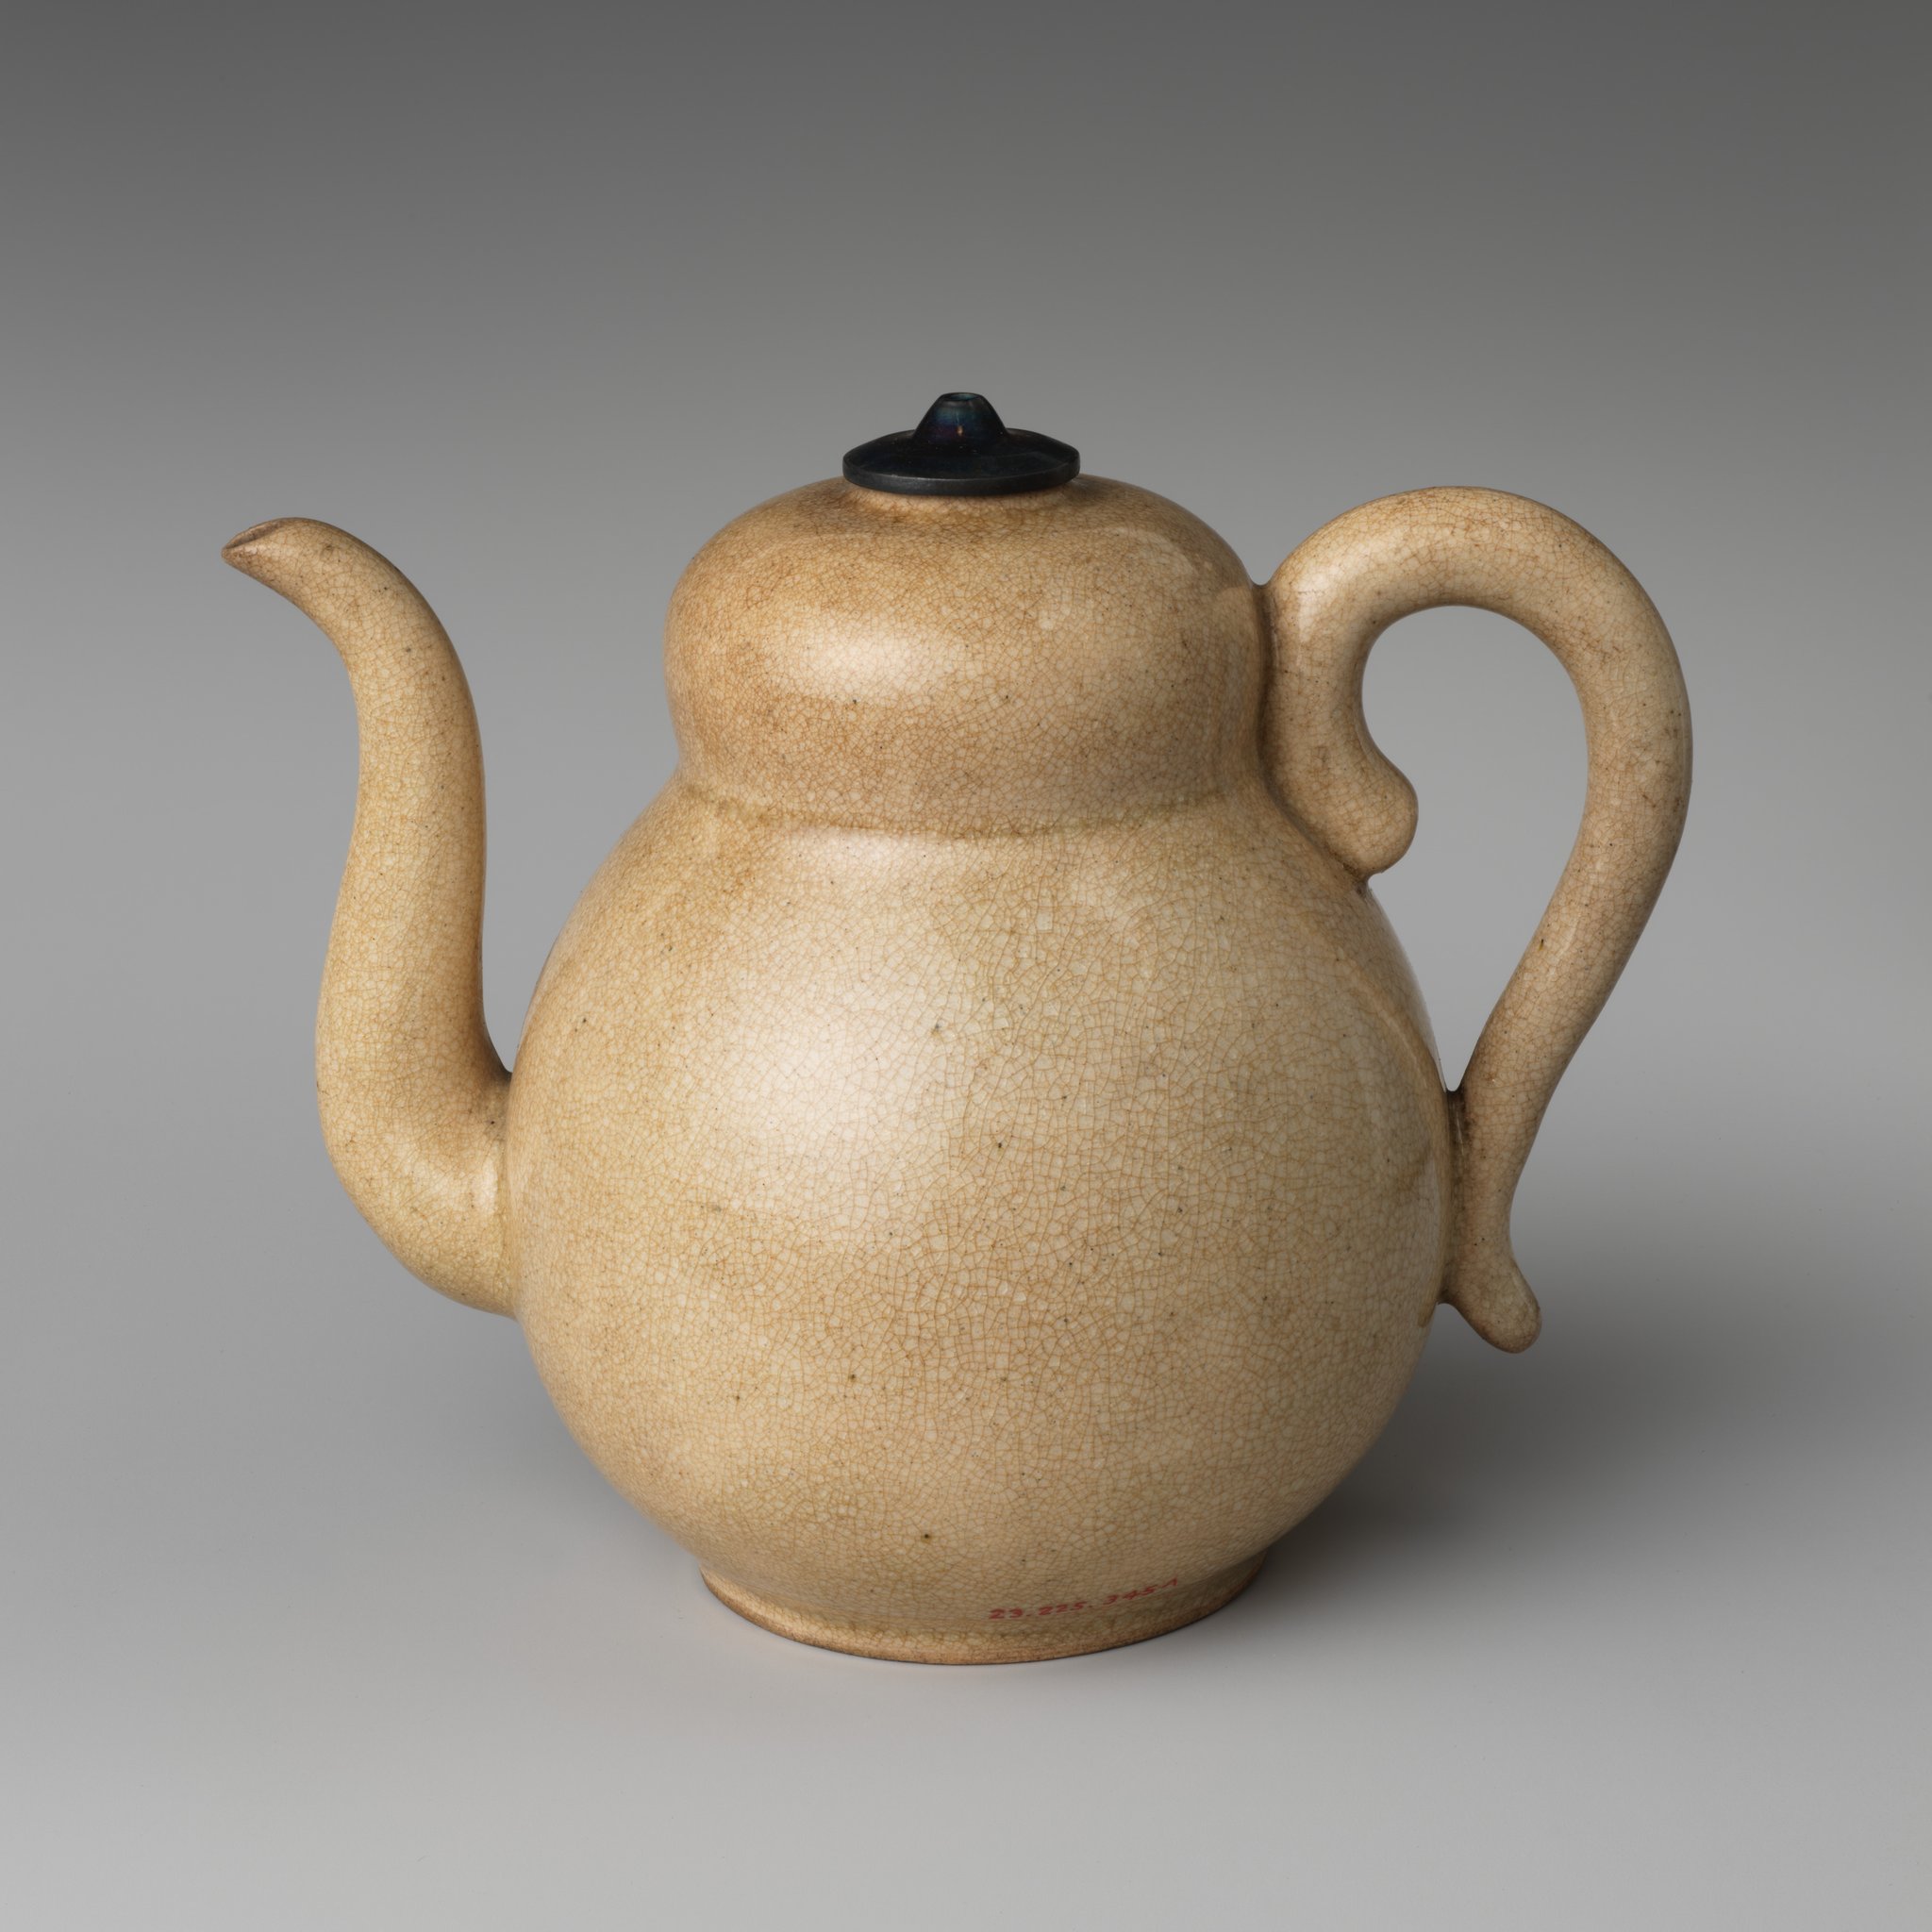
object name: water pitcher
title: Sencha Water Pitcher (Suichū)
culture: japanese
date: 1801-1833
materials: glaze, stoneware